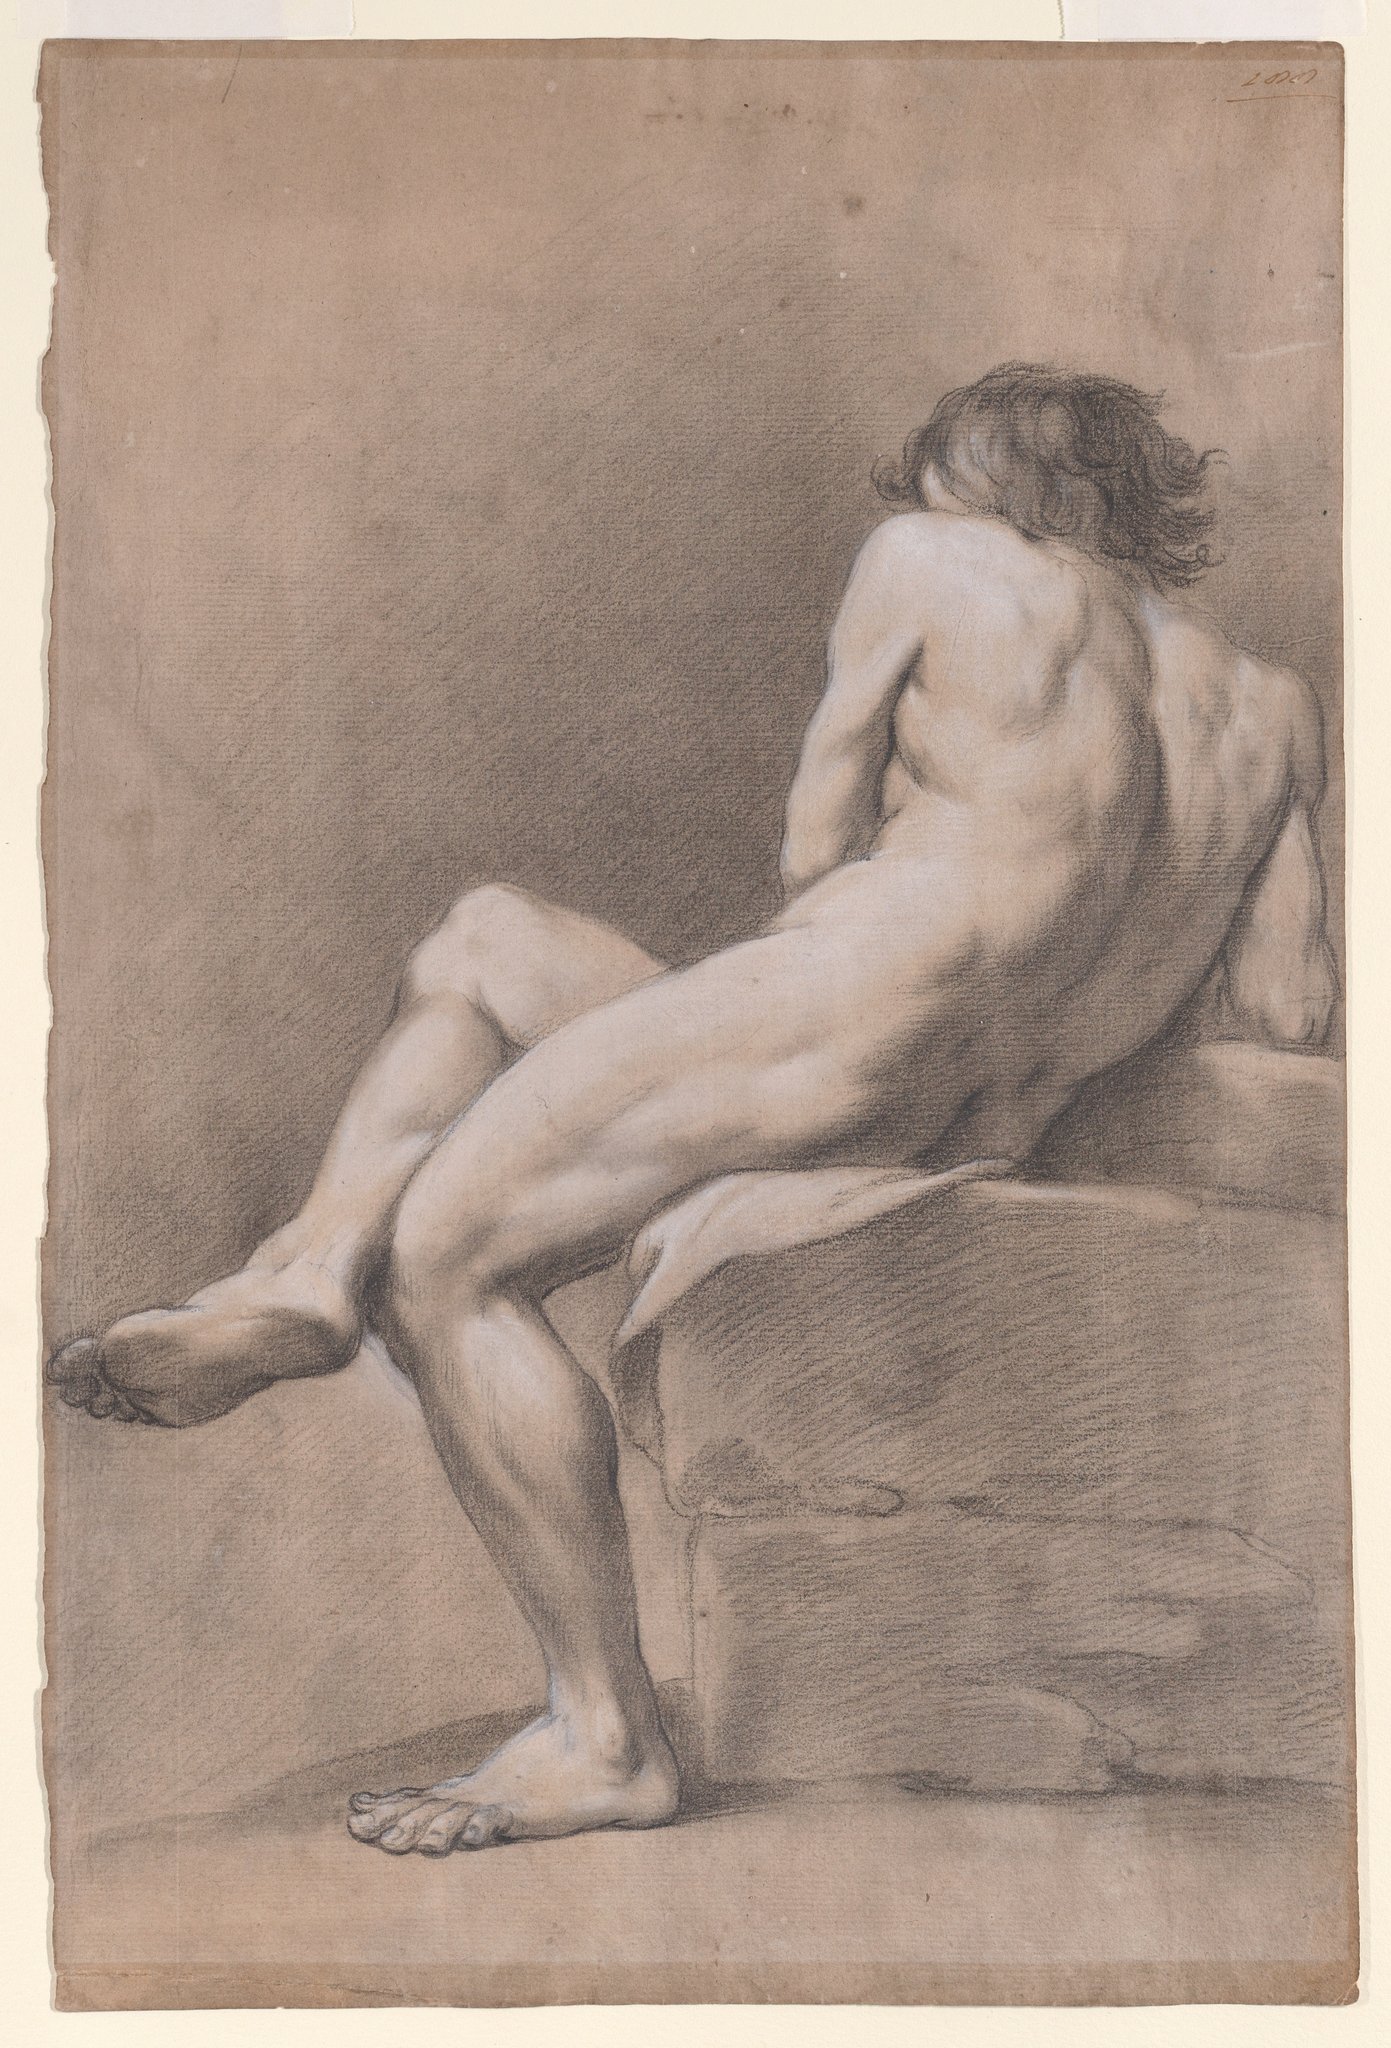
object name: drawing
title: Finished Academy Study of a Seated Male Figure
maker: giacomo zoboli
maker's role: artist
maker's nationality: italian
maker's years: 1681-1767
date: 1701-1800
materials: chalk, paper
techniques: highlighting, tinting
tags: male nudes